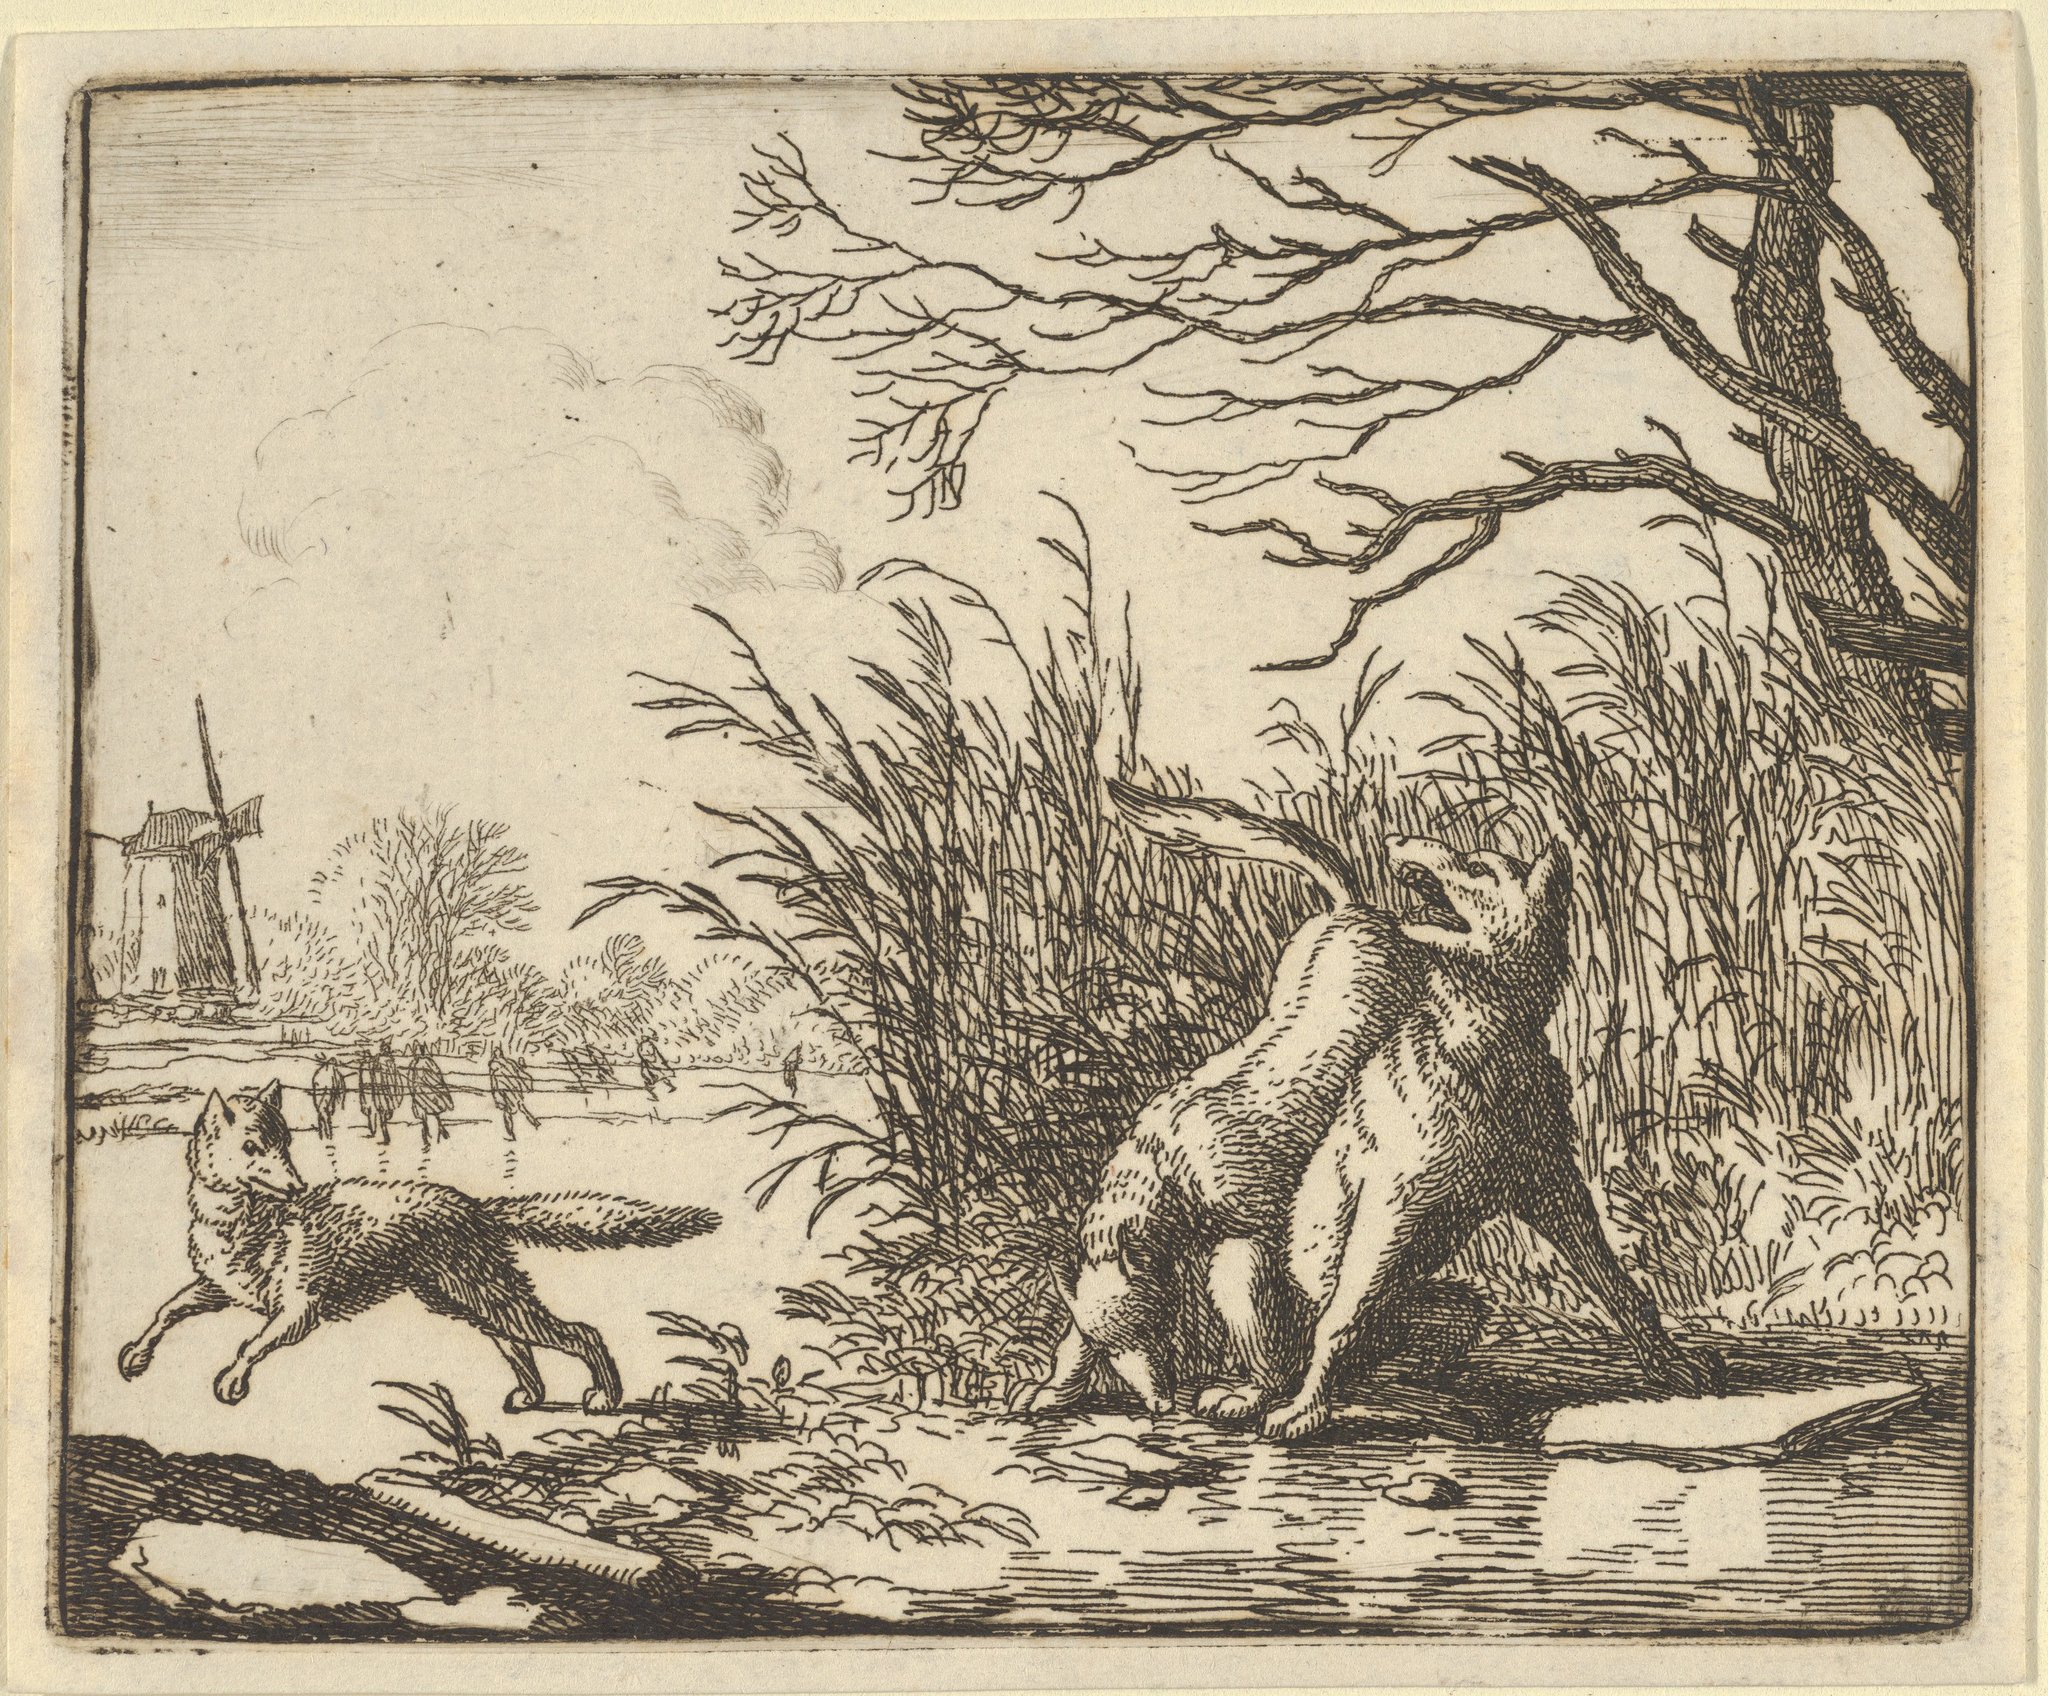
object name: print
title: The Wolf Accuses Renard Once Again from Hendrick van Alcmar's Renard The Fox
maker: allart van everdingen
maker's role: artist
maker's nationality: dutch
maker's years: 1621-1675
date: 1650-1675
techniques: engraving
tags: foxes